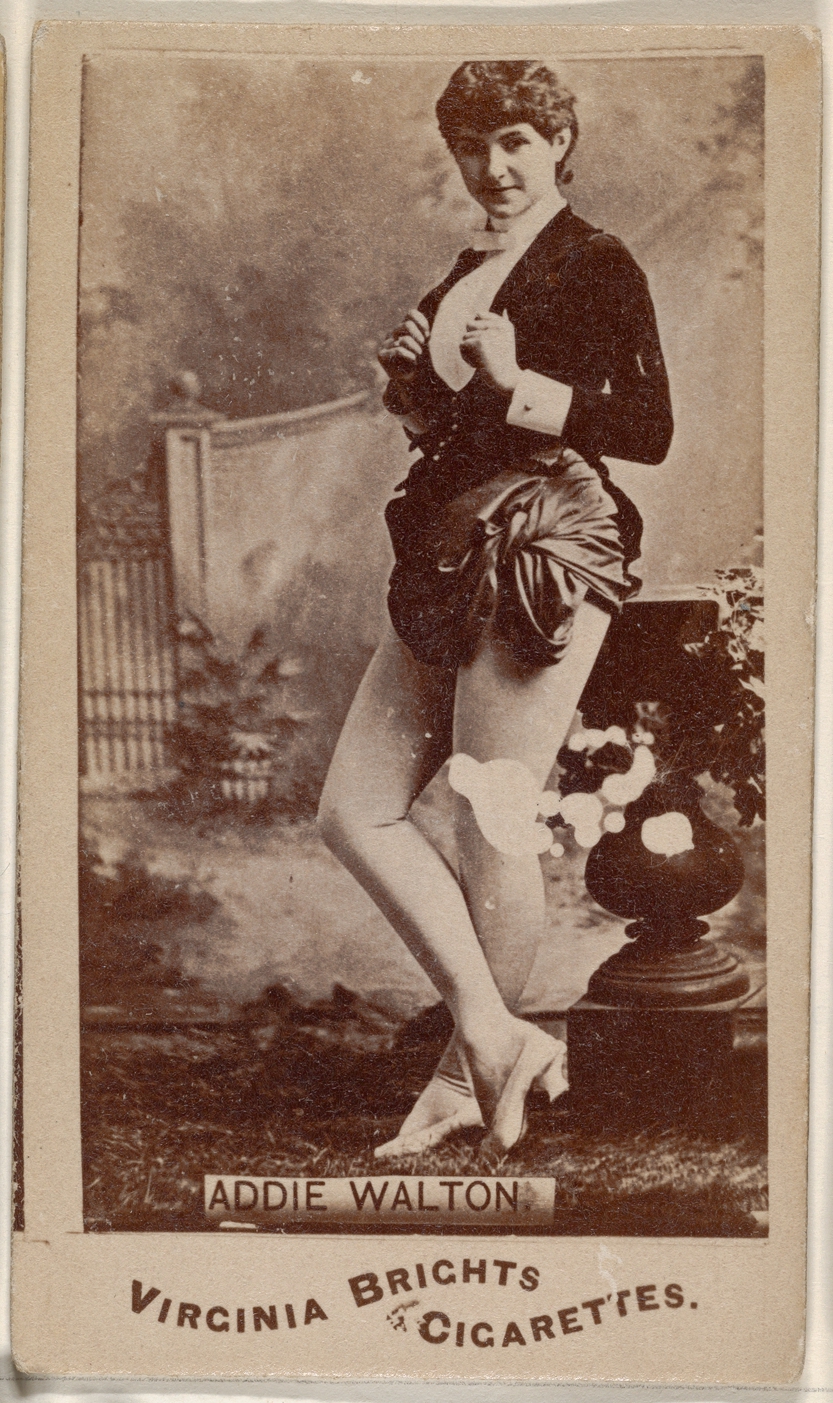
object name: photograph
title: Addie Walton, from the Actors and Actresses series (N45, Type 1) for Virginia Brights Cigarettes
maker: allen & ginter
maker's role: publisher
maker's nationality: american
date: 1888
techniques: albumen silver print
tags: portraits,women,actresses